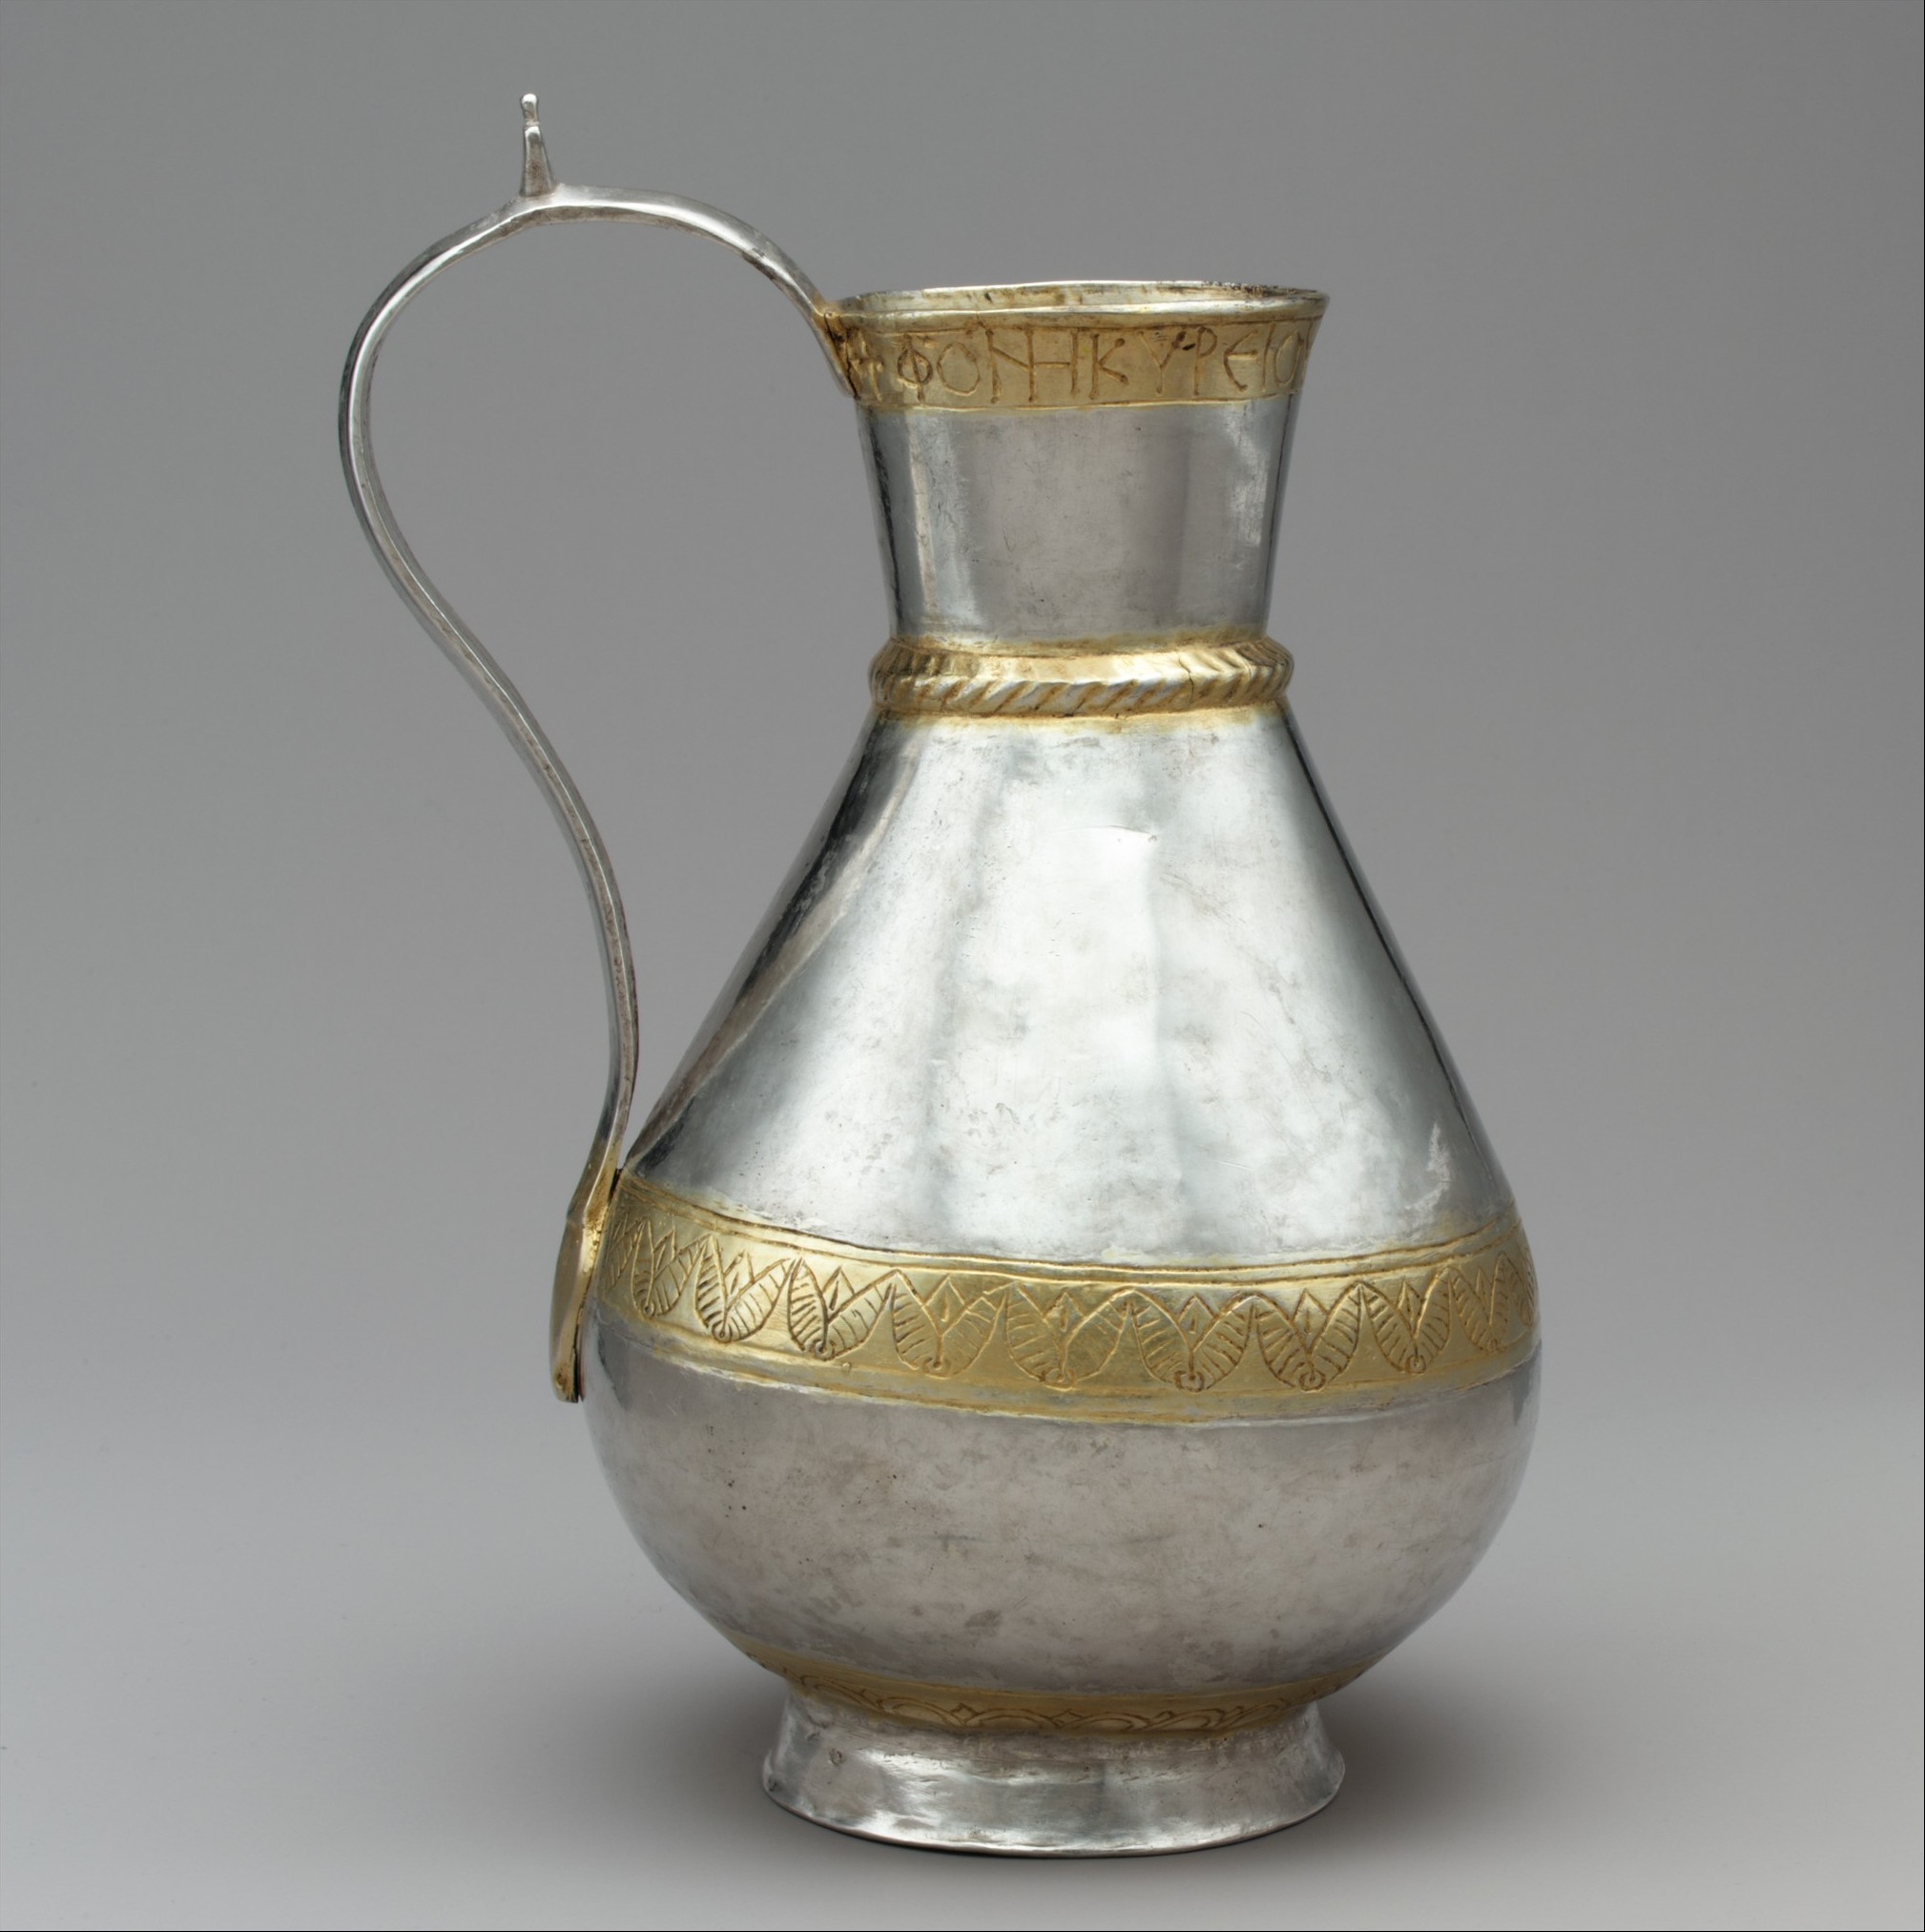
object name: ewer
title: Ewer of Zenobius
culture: avar or byzantine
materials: gilt, silver